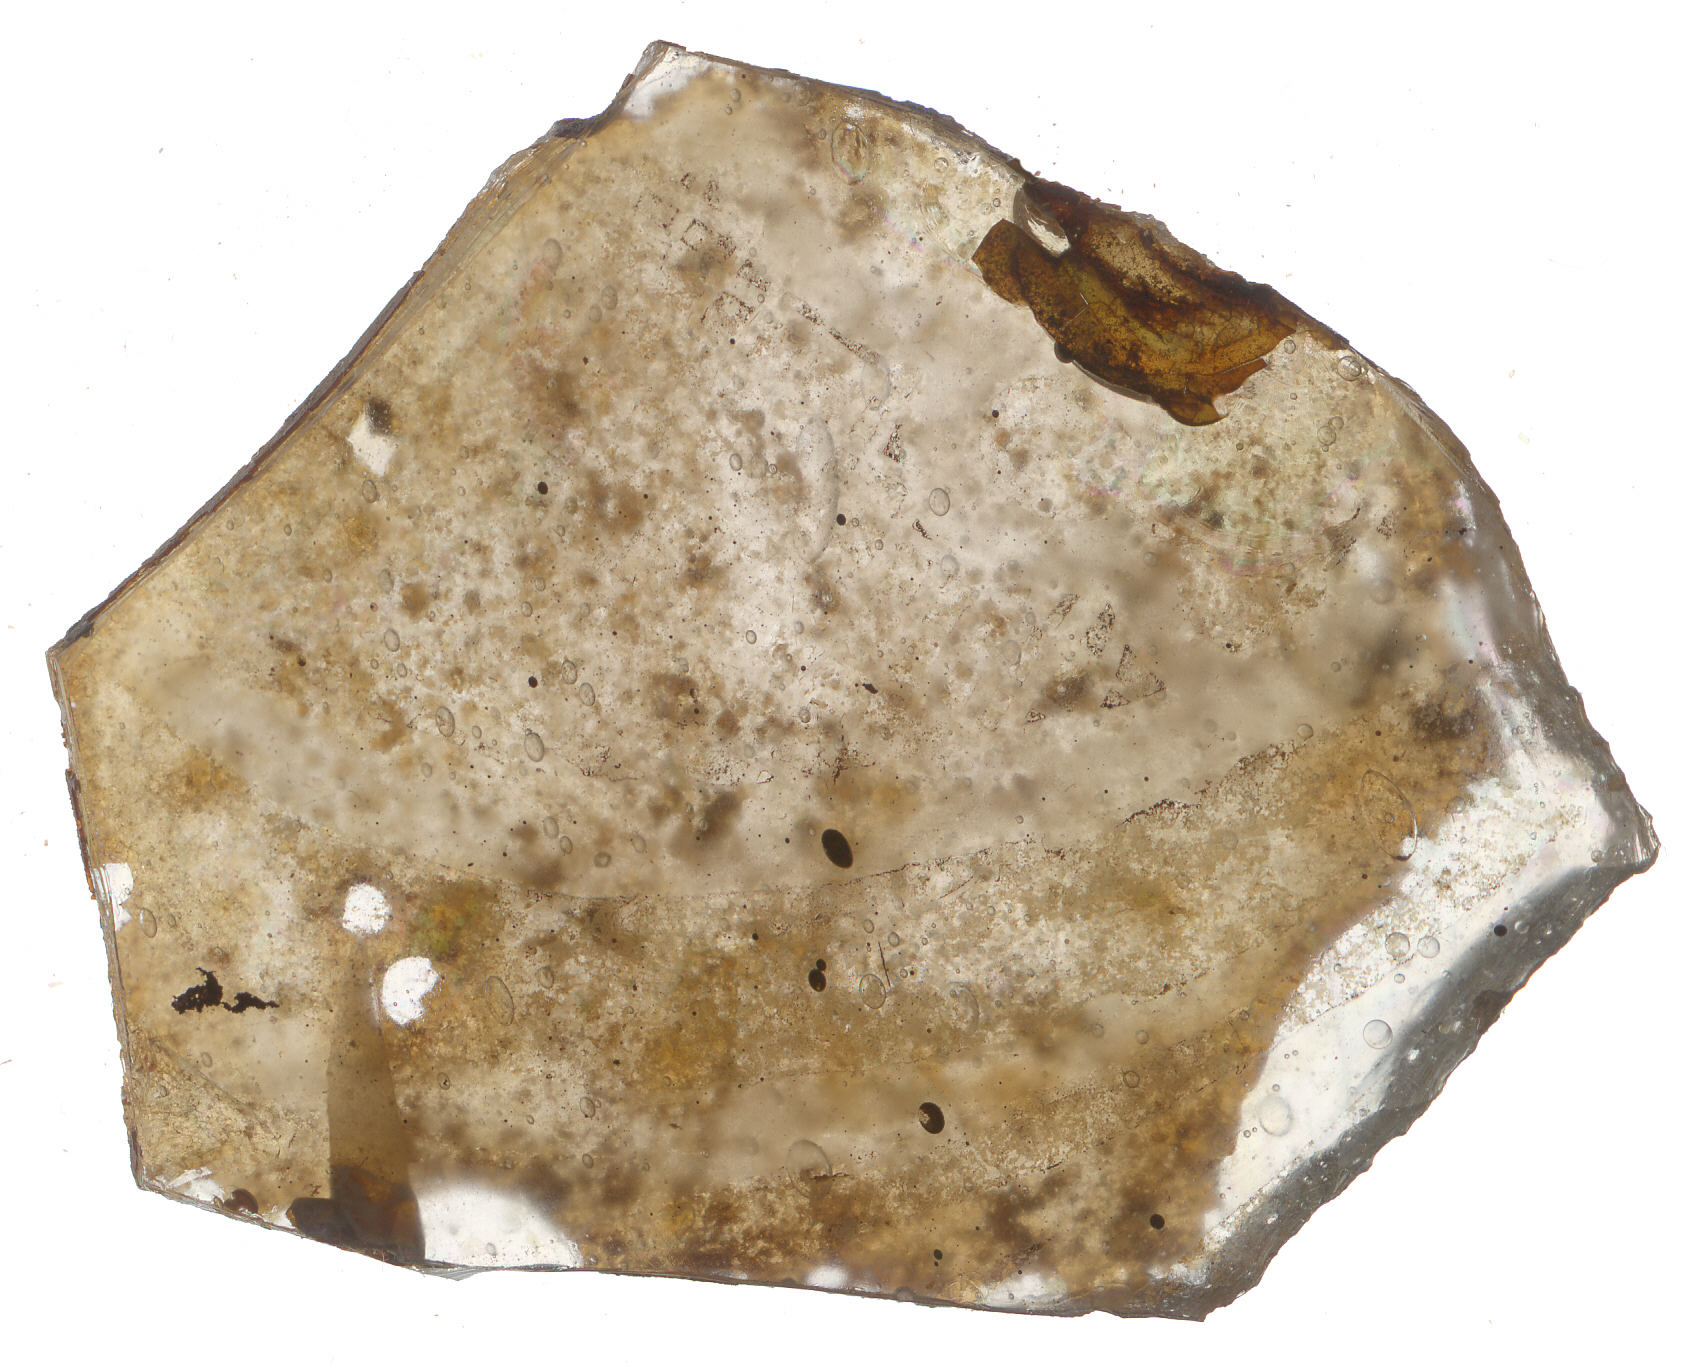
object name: fragment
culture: crusader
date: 1201-1300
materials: glass